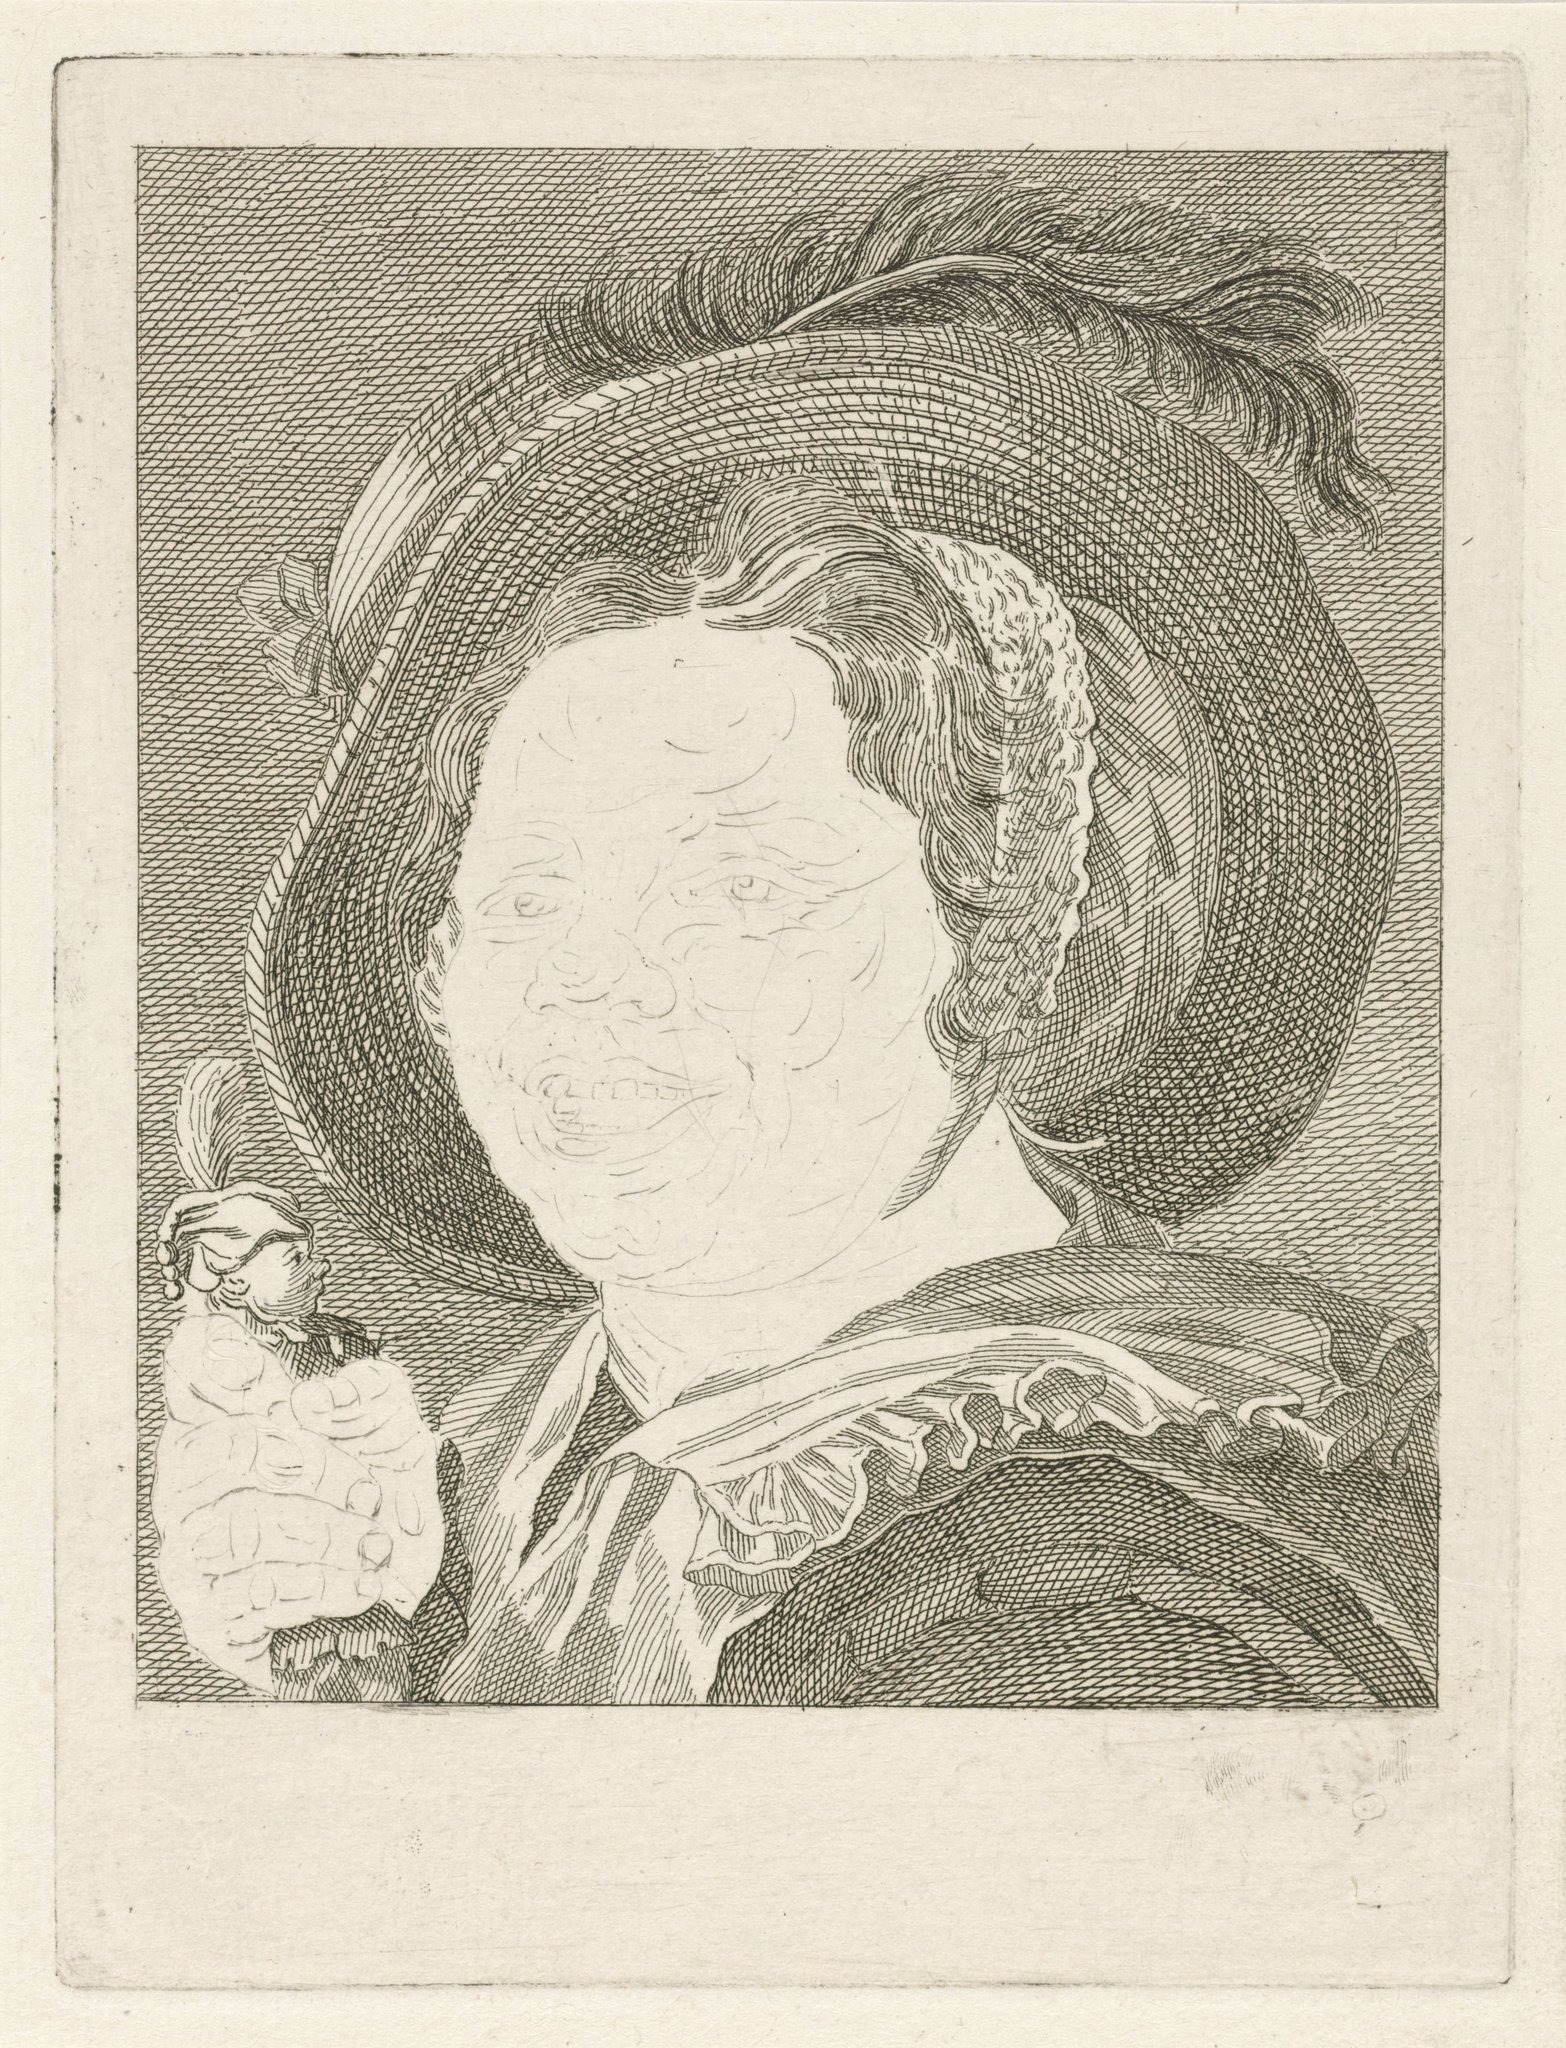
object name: print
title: Lachend meisje met pop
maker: pieter de mare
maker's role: print maker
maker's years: 1758-1796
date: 1768-1796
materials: paper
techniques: etching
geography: leiden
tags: child, (playing with) dolls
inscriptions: collector's mark: Lugt 240